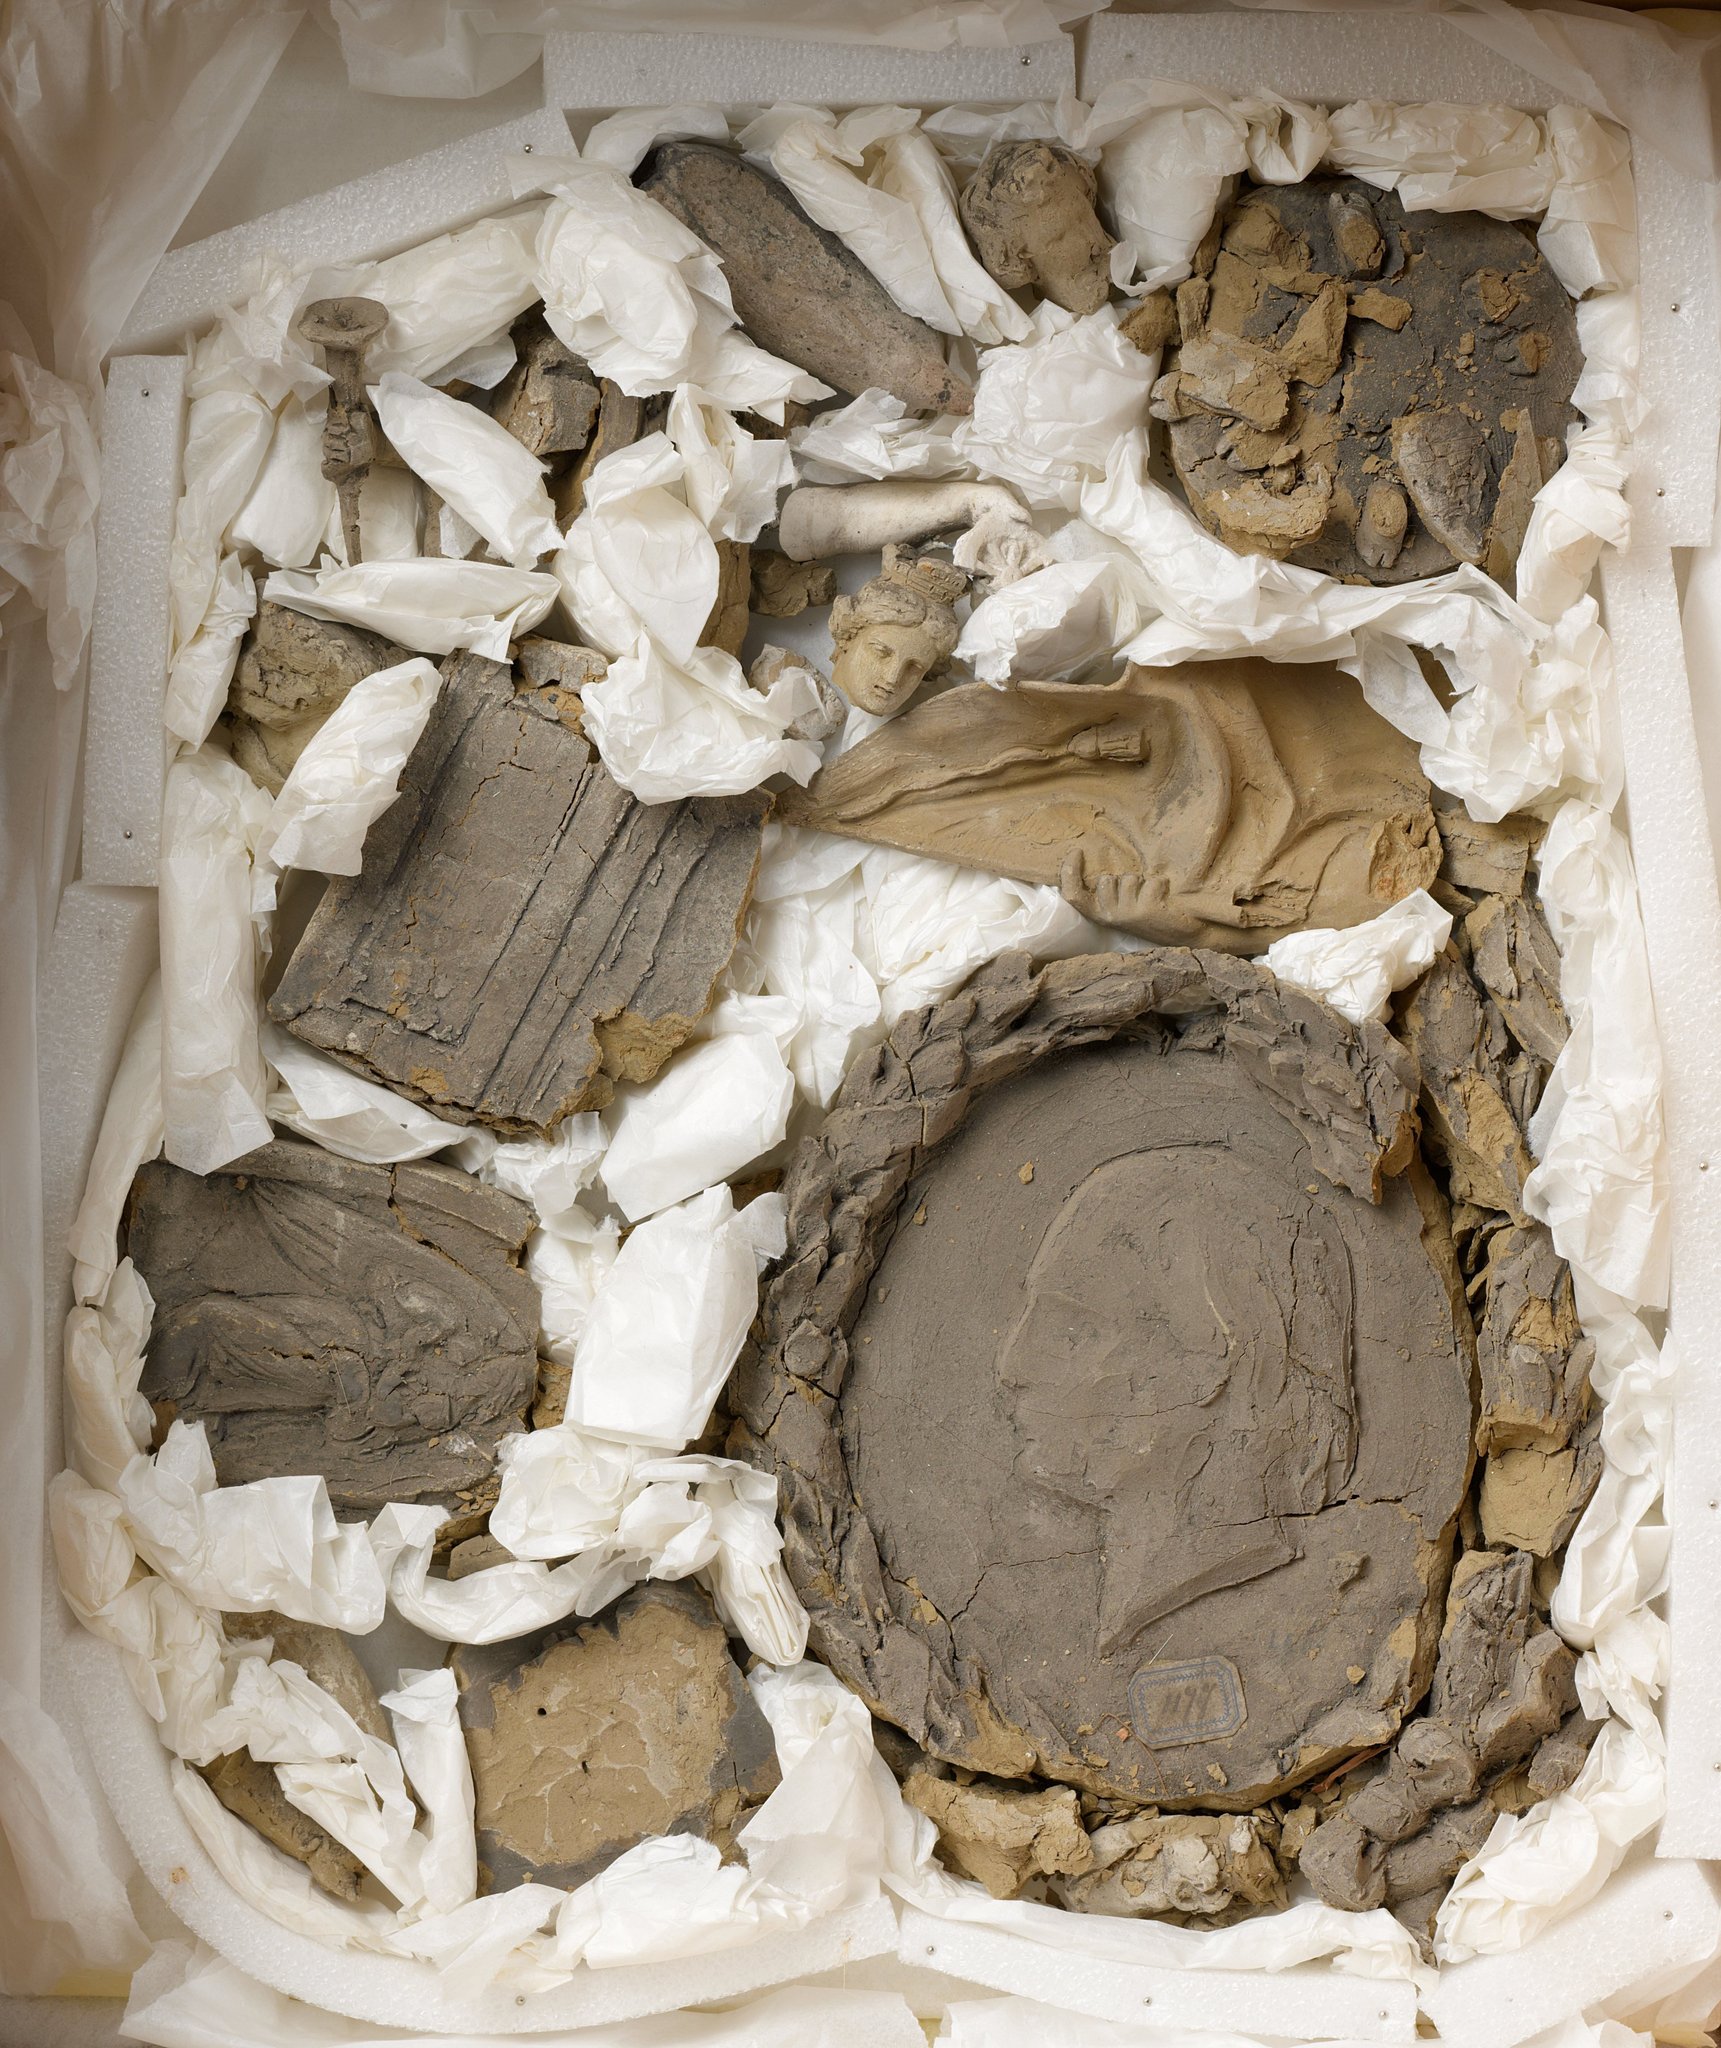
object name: sculpture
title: Medaillonportret in een krans van loofwerk, ovaal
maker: eugène lacomblé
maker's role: draughtsman, painter, sculptor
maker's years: 1828-1905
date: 1800-1950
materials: clay